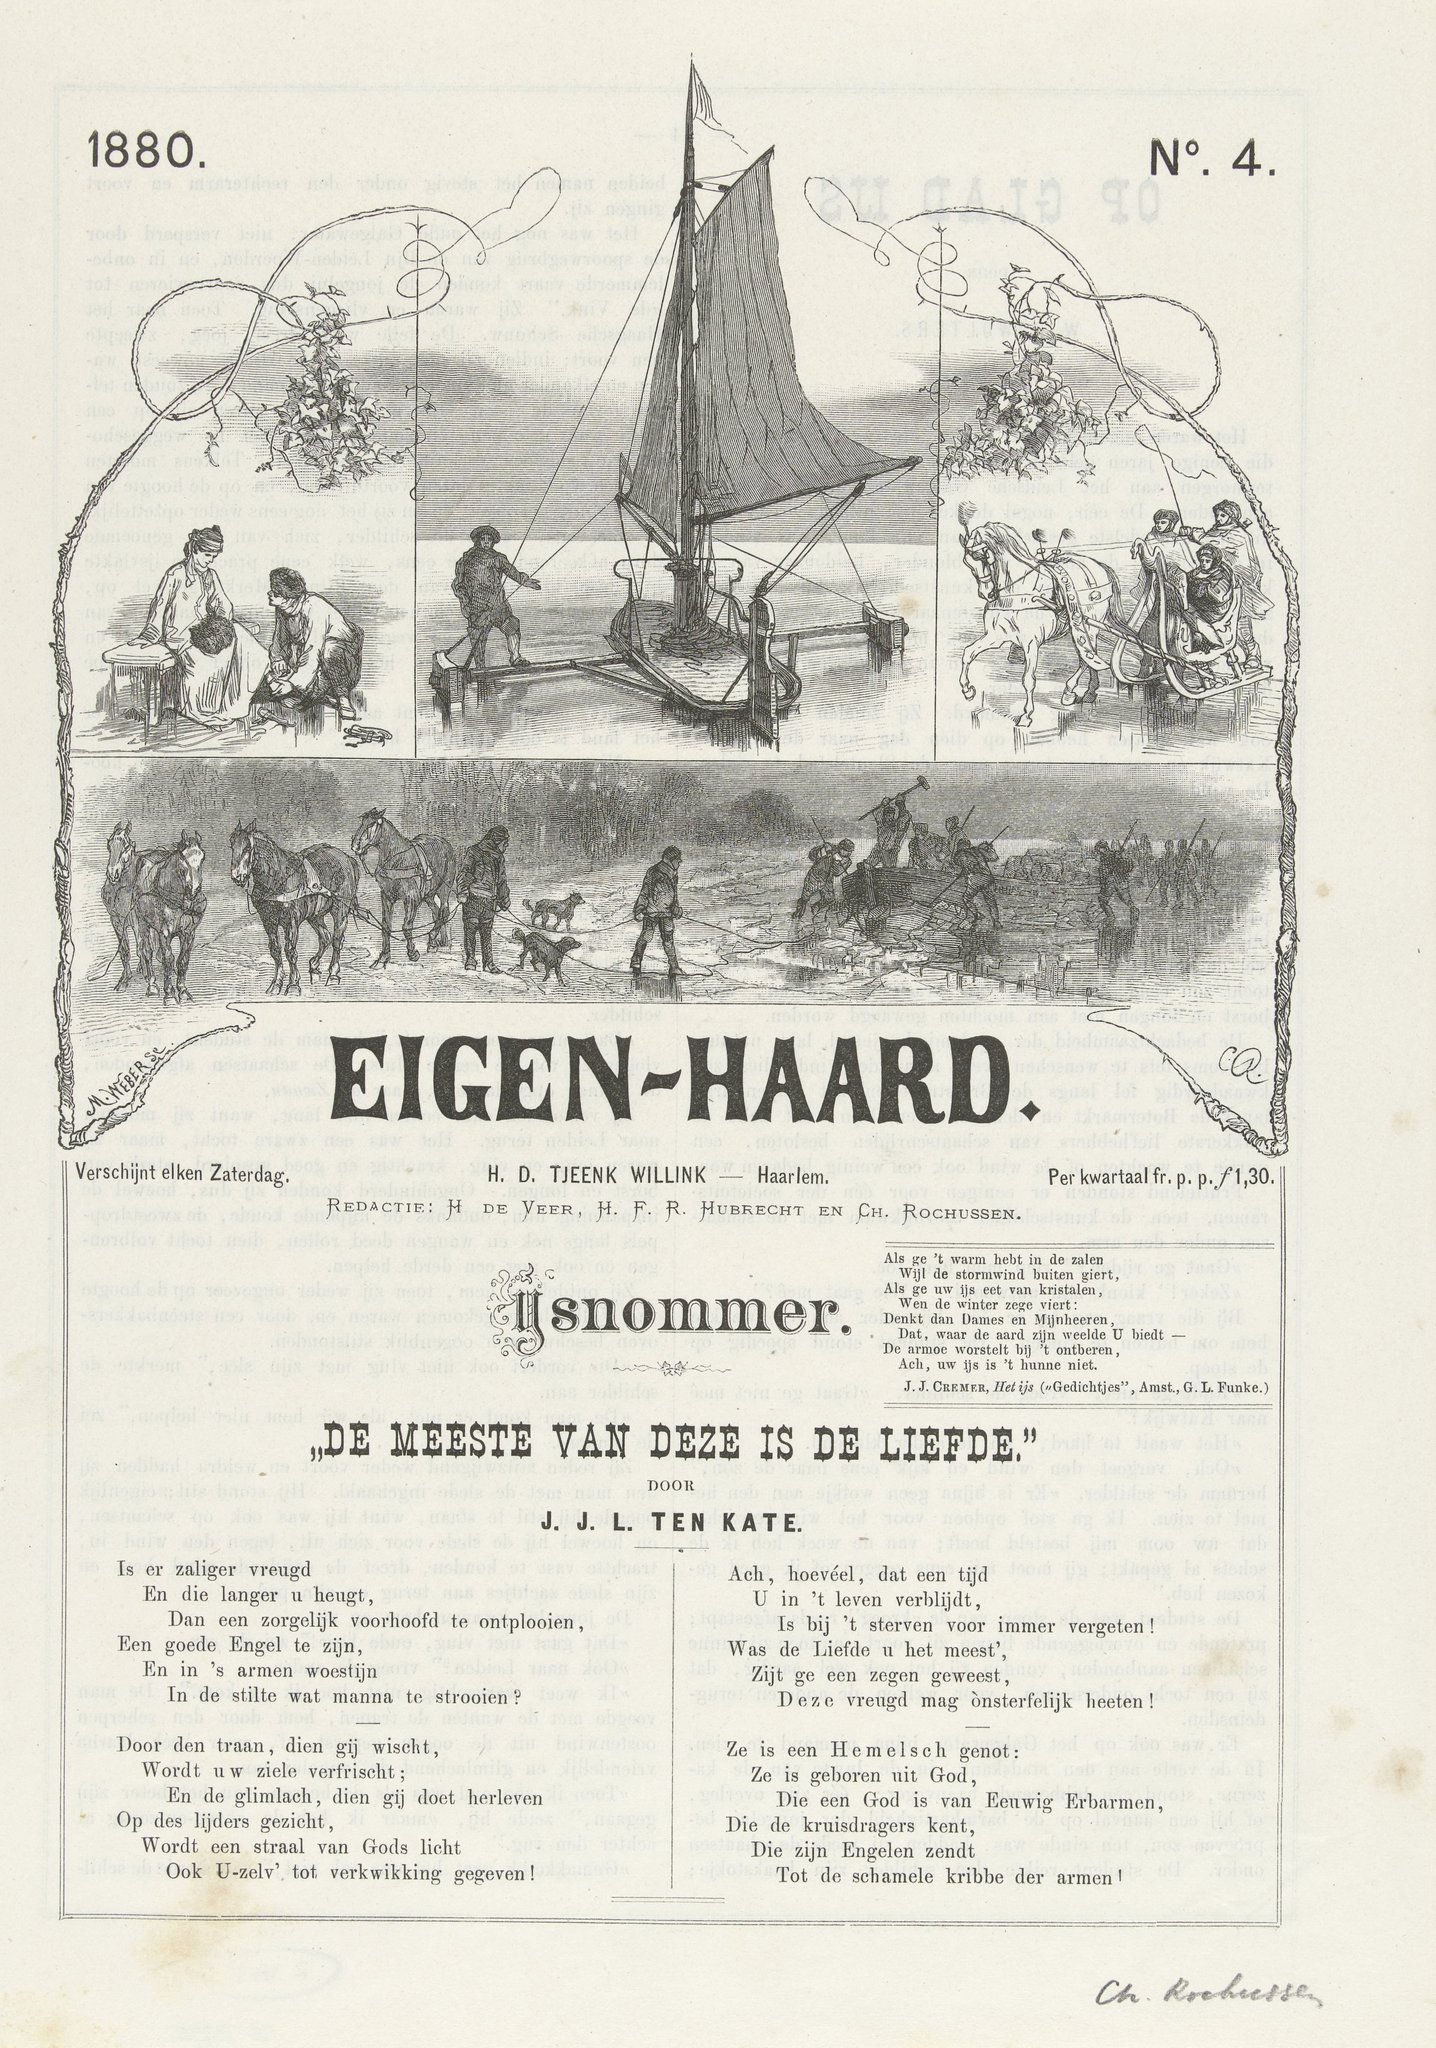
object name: titelblad, titelpagina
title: Titelpagina voor 'Eigen-Haard'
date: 1880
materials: paper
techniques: letterpress printing, engraving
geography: netherlands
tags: ice-sailing (winter sports), sledge, sleigh (winter sports), ice ~ state of water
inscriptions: collector's mark: Lugt 2228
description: Titelpagina voor het tijdschrift 'Eigen-Haard' met vier afbeeldingen van situaties op het ijs. Onder de afbeelding twee gedichten.